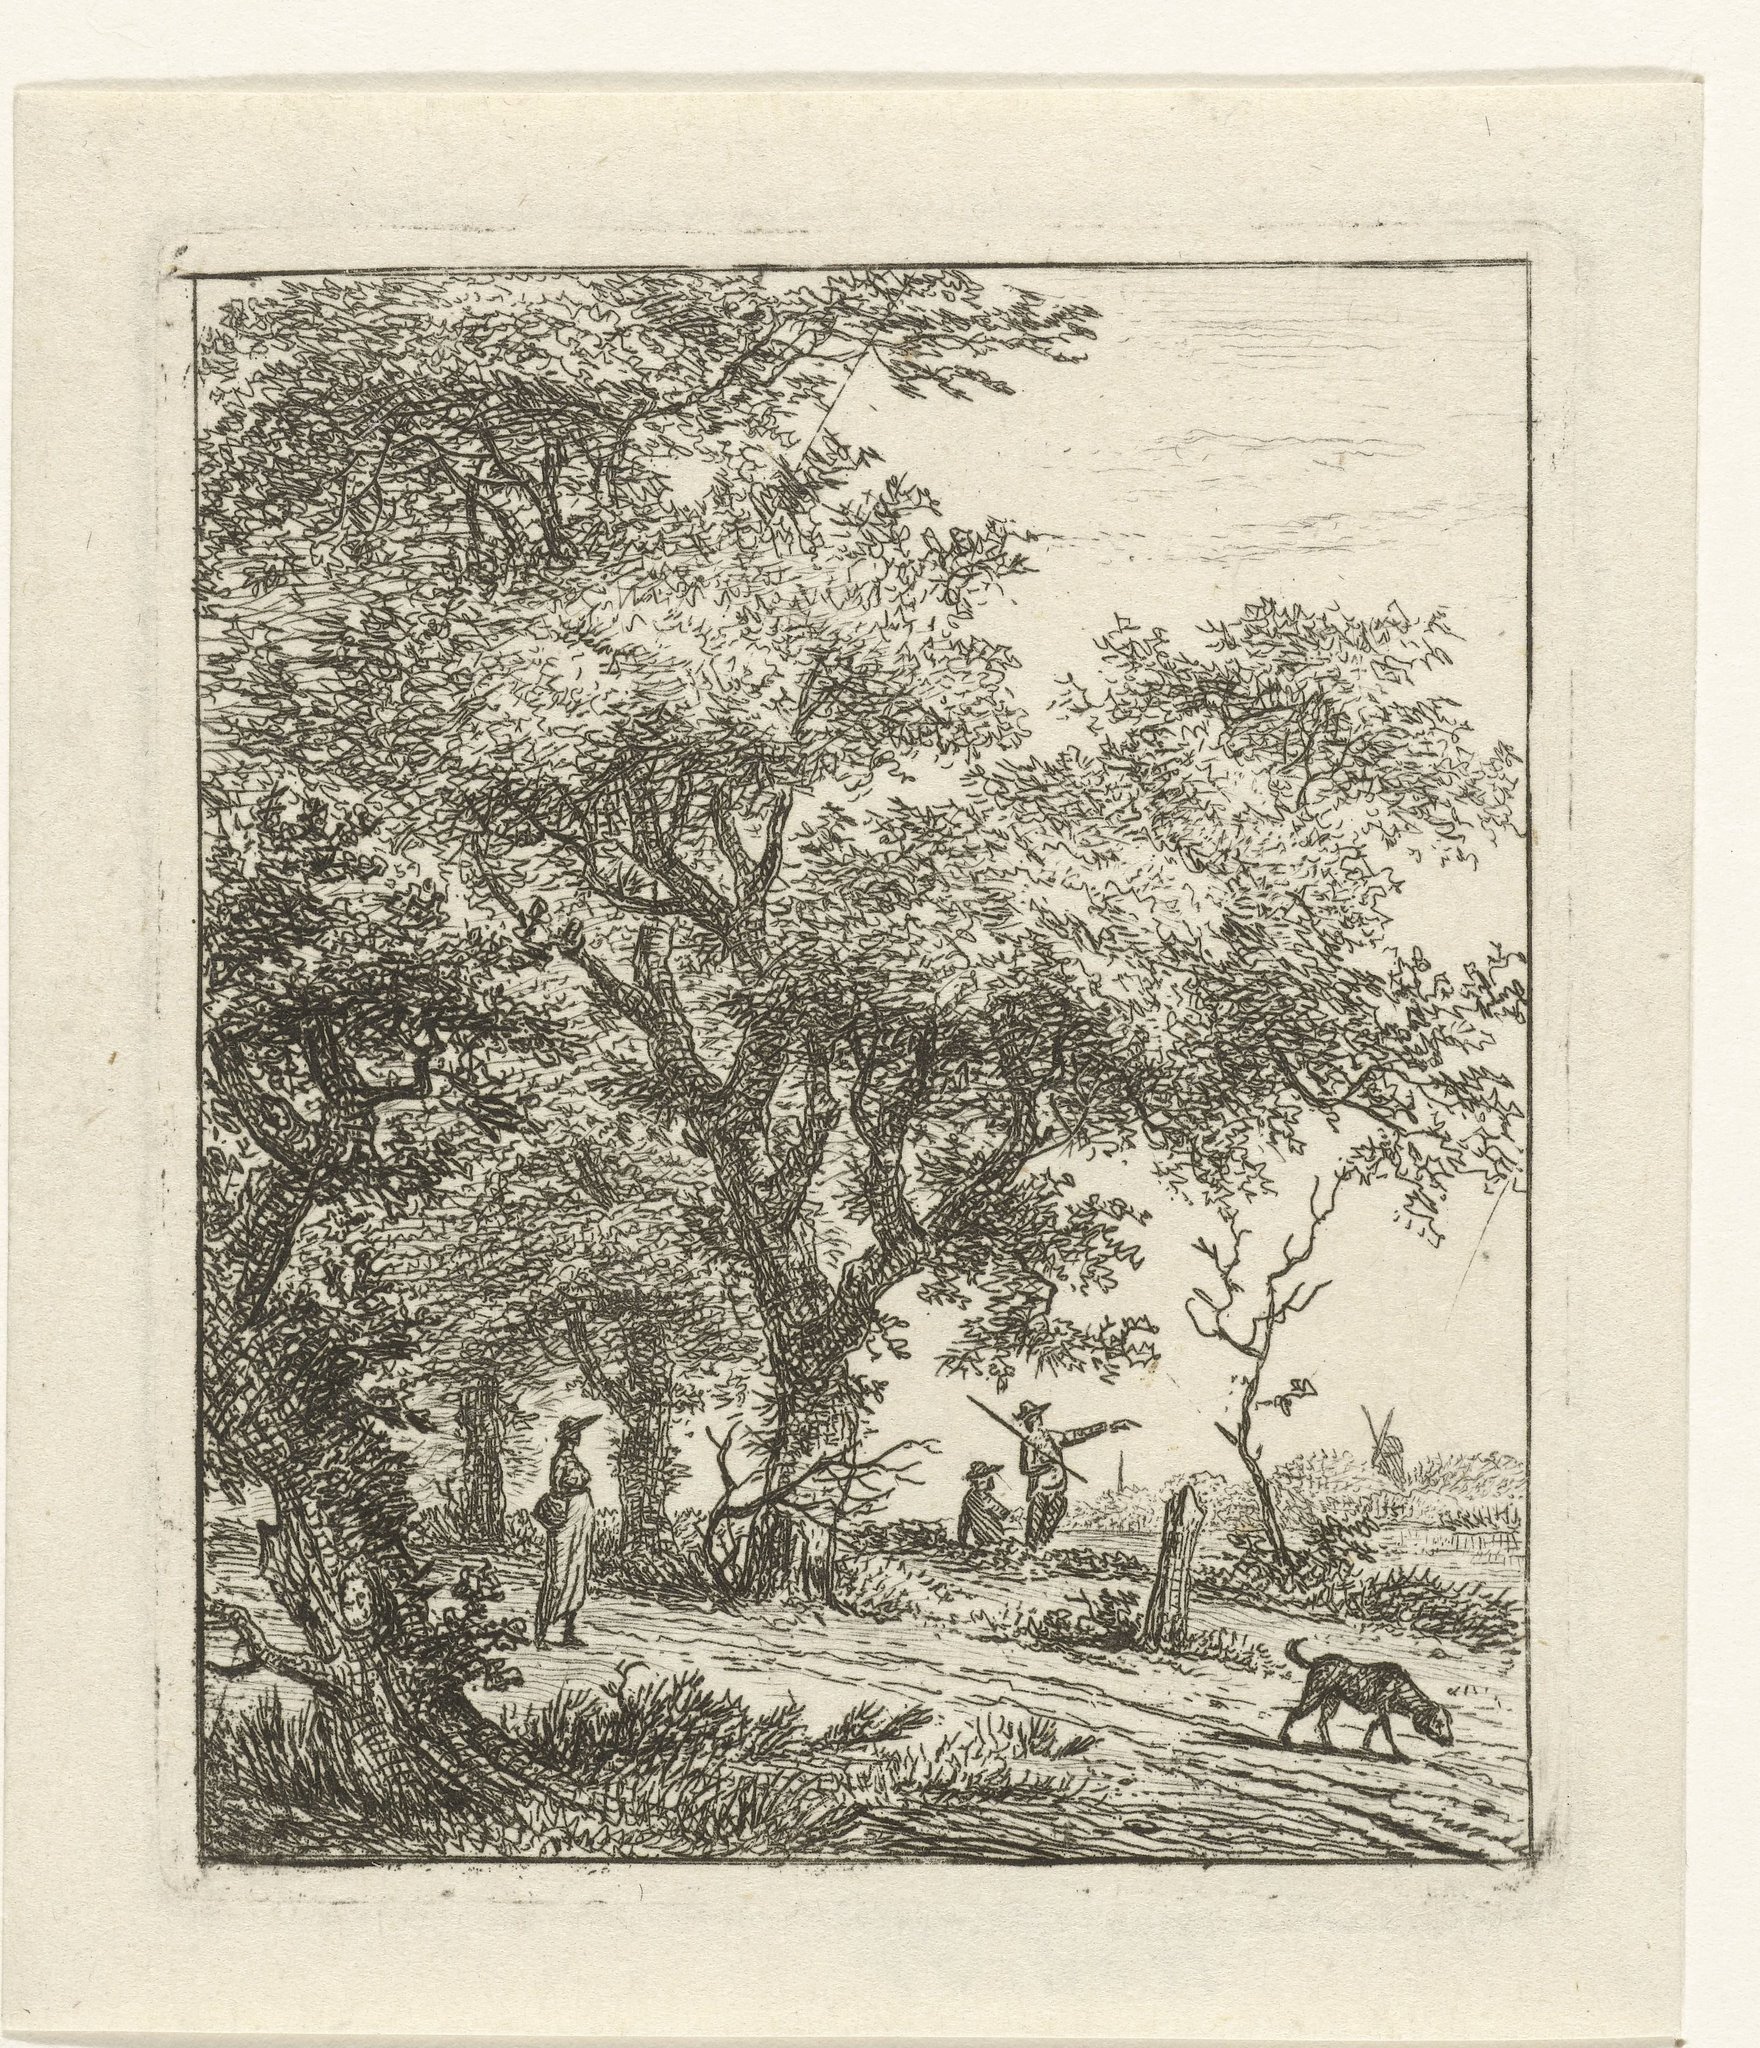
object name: print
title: Landschap met vrouw en hond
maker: hermanus fock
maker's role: conservator, draughtsman, painter, print maker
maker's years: 1766-1822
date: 1781-1822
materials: paper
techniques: etching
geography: amsterdam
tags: landscapes (+ landscape with figures, staffage), dog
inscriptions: collector's mark: Lugt 2228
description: Op een pad tussen hoge bomen loopt een vrouw met verderop een hond. Naast het pad staat een man met een uitgestrekte arm bij een zittend persoon.